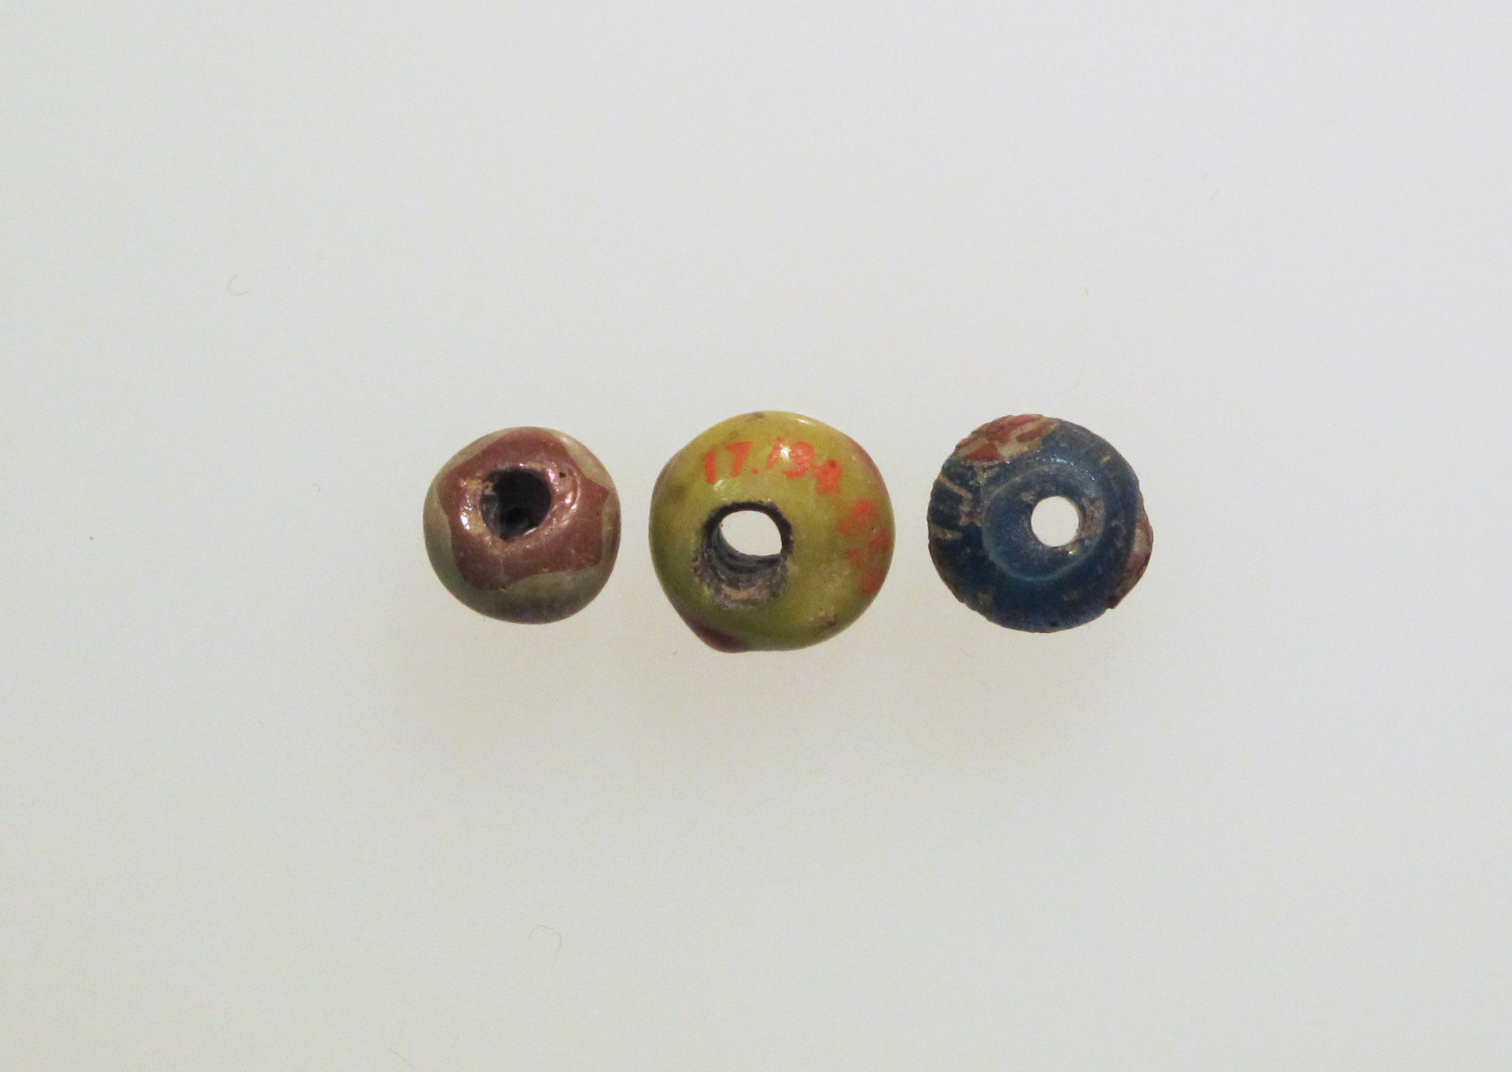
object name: bead, 3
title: Beads, 3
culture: roman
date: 670 BCE-330 CE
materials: glass